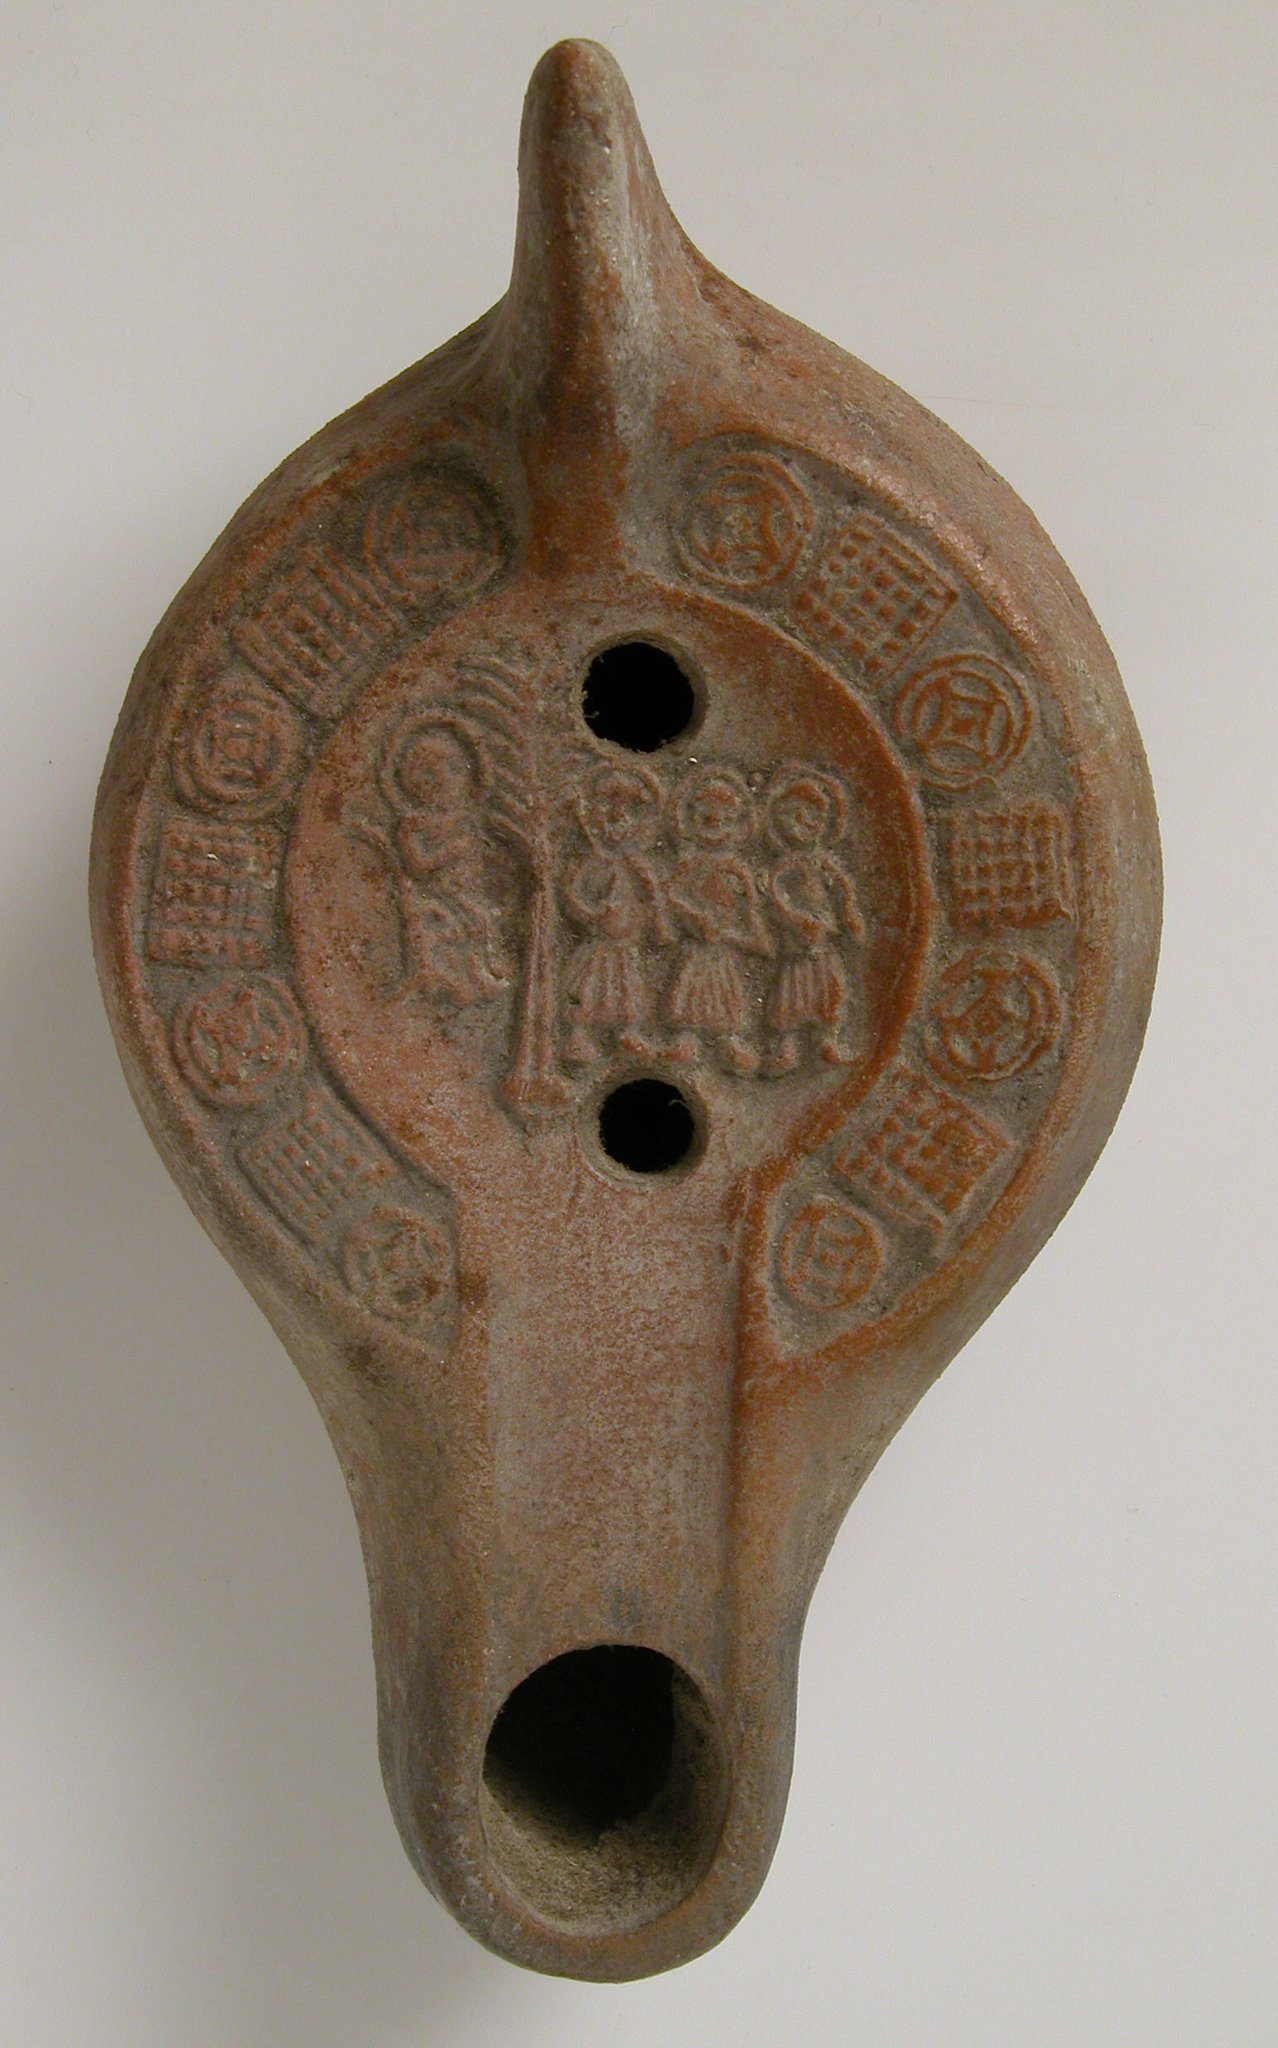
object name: lamp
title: Lamp with the Three Hebrews before Nebuchadnezzar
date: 401-600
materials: earthenware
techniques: molding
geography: tunisia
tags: human figures